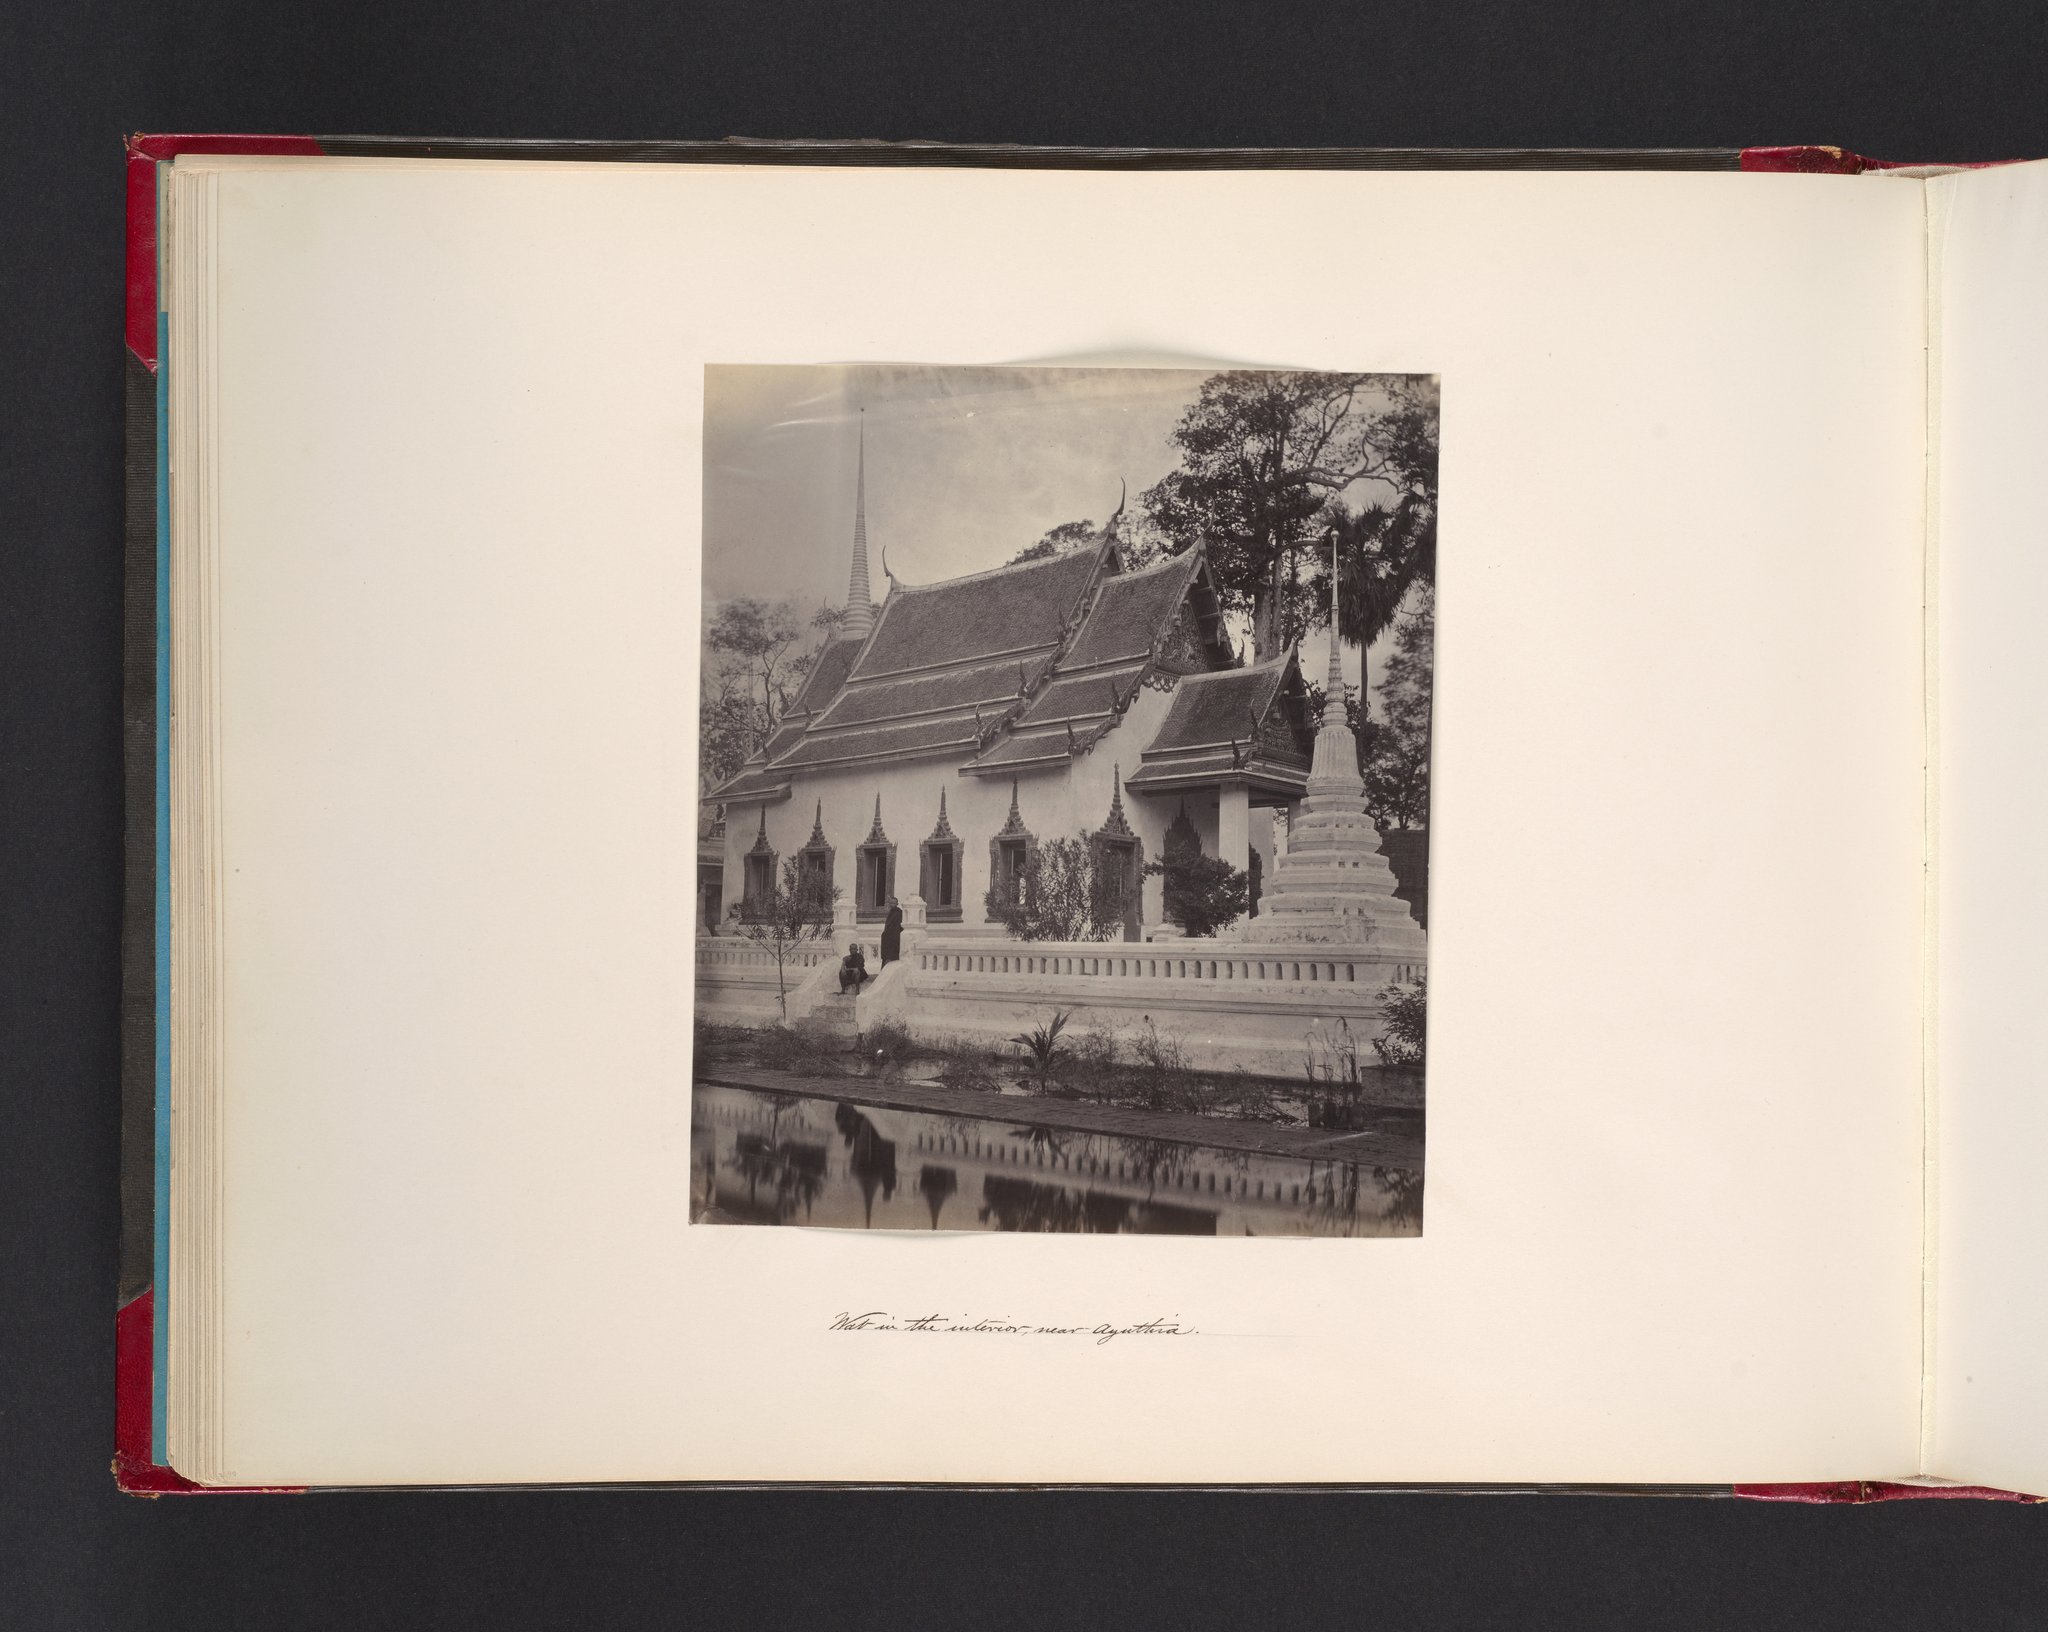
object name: photograph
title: Wat in the Interior, near Ayuthia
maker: john thomson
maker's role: artist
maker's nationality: british, scottish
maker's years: 1837-1921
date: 1865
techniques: albumen silver print, glass negative